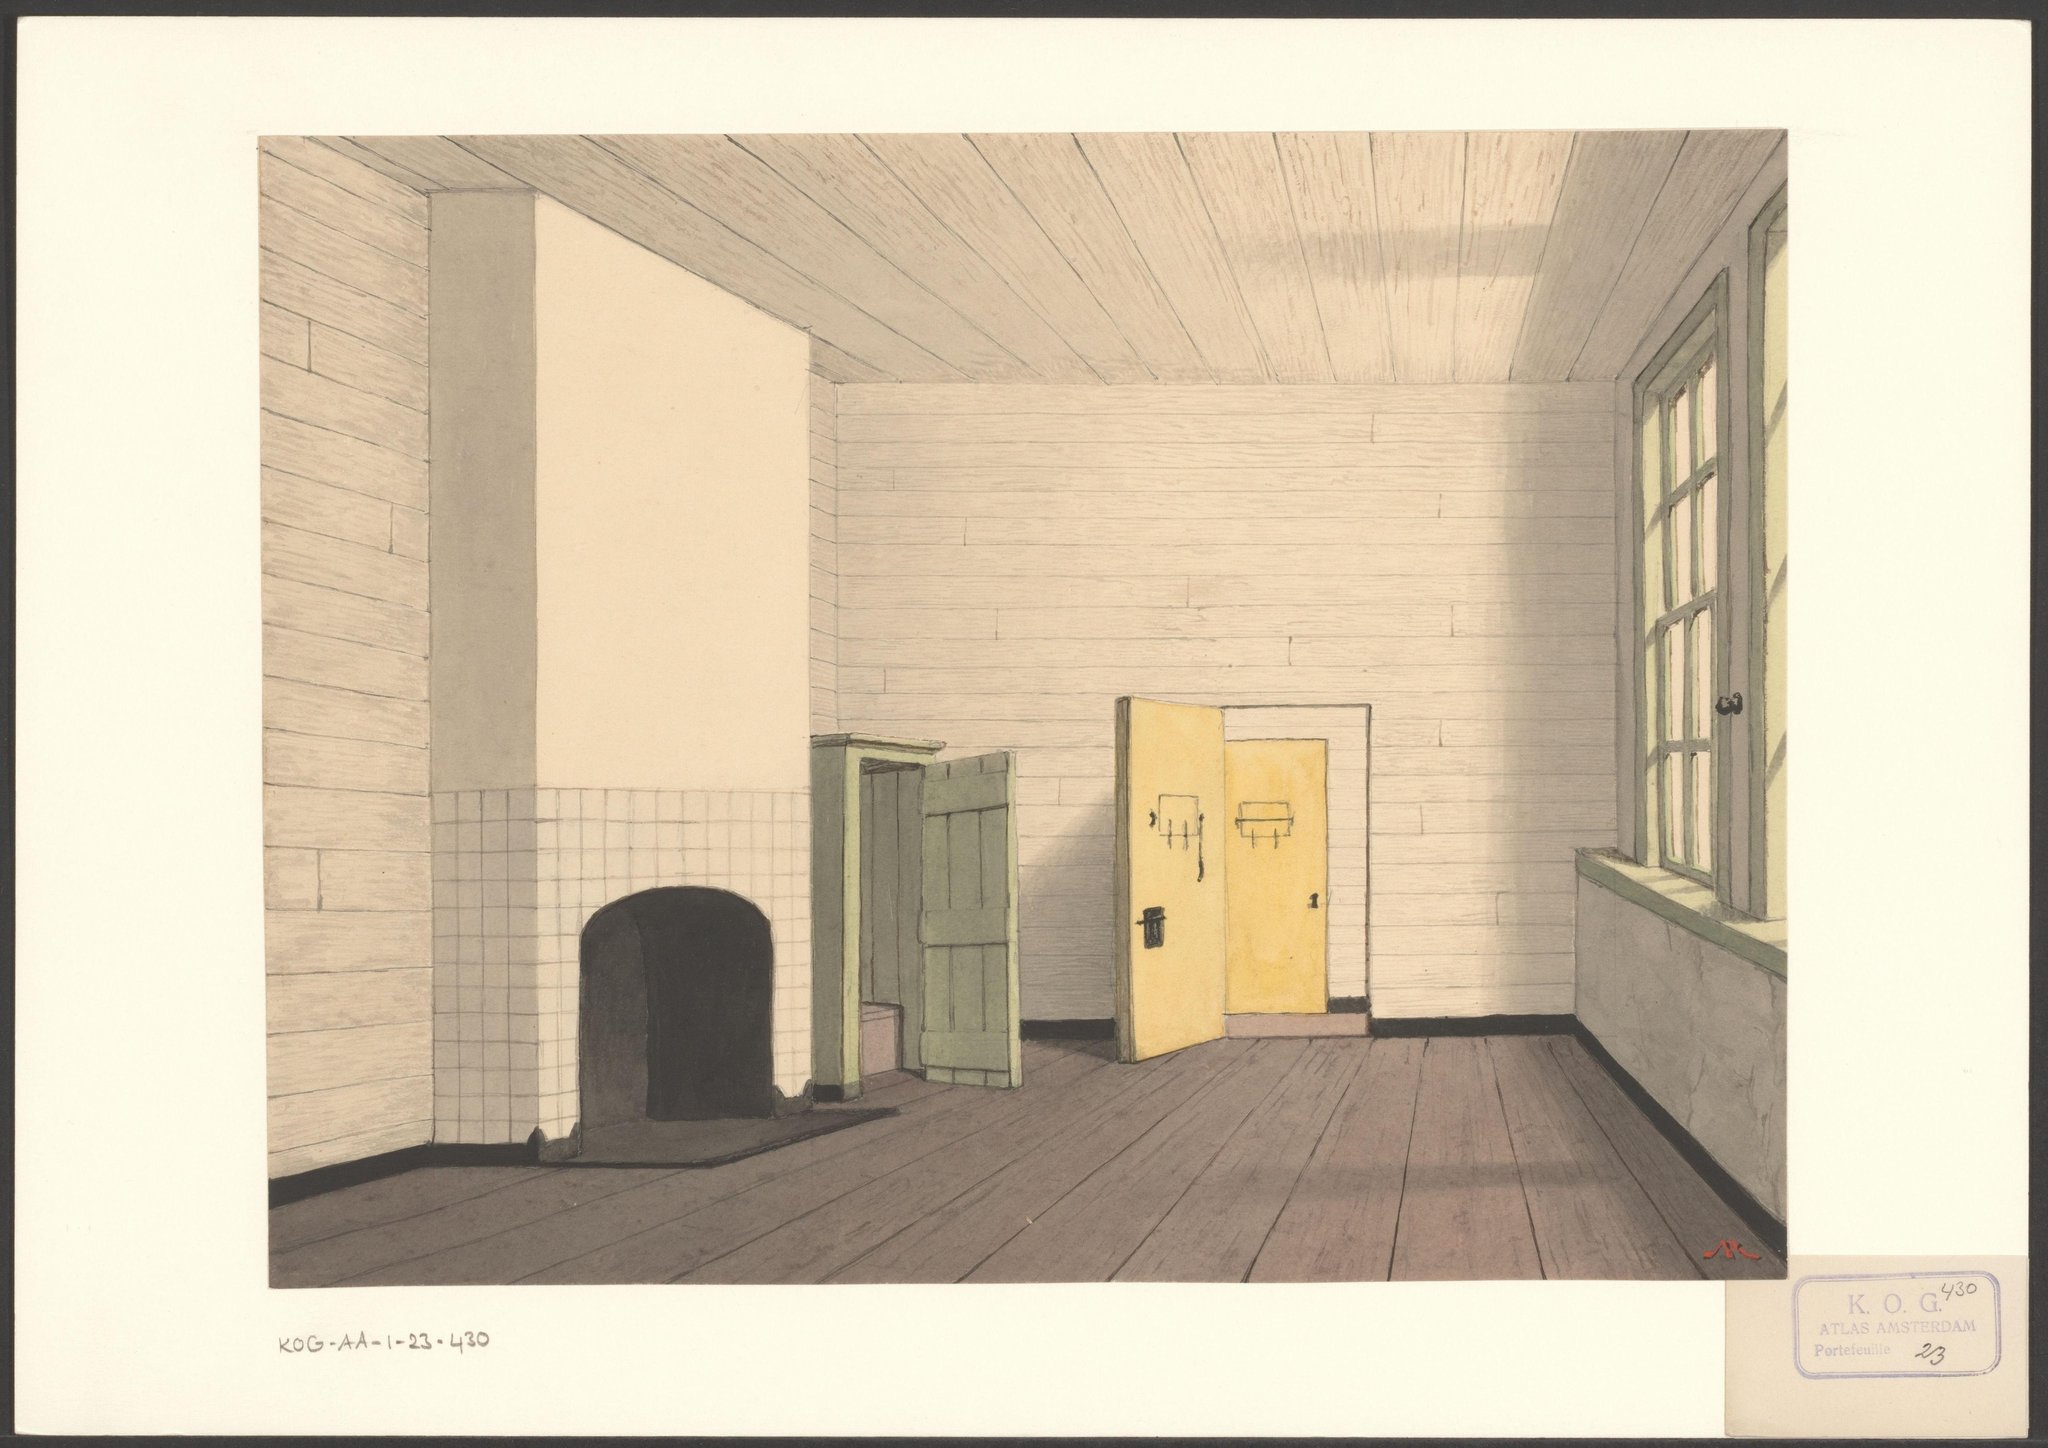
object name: drawing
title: Interieur van een cel in het Tucht- of Rasphuis aan de Heiligeweg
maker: johan martinus anthon rieke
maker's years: 1851-1899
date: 1895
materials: gouache, ink, paper, pencil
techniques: brush, pen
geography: amsterdam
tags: prison, jail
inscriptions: inscription: ‘Port. 23-430’, collector's mark: ‘23’ Lugt 1641b, collector's mark: Lugt 1641a, stamp: ‘K.O.G.’, signature: ‘JMAR’, signature, date and inscription: ‘Cel in het (...) fec 1895 Amsterdam’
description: Onderwerpsrubriek binnen de Atlas Amsterdam: Handvesten, Keuren, enz.; Rechtswezen (incl. gevangenissen, enz.).